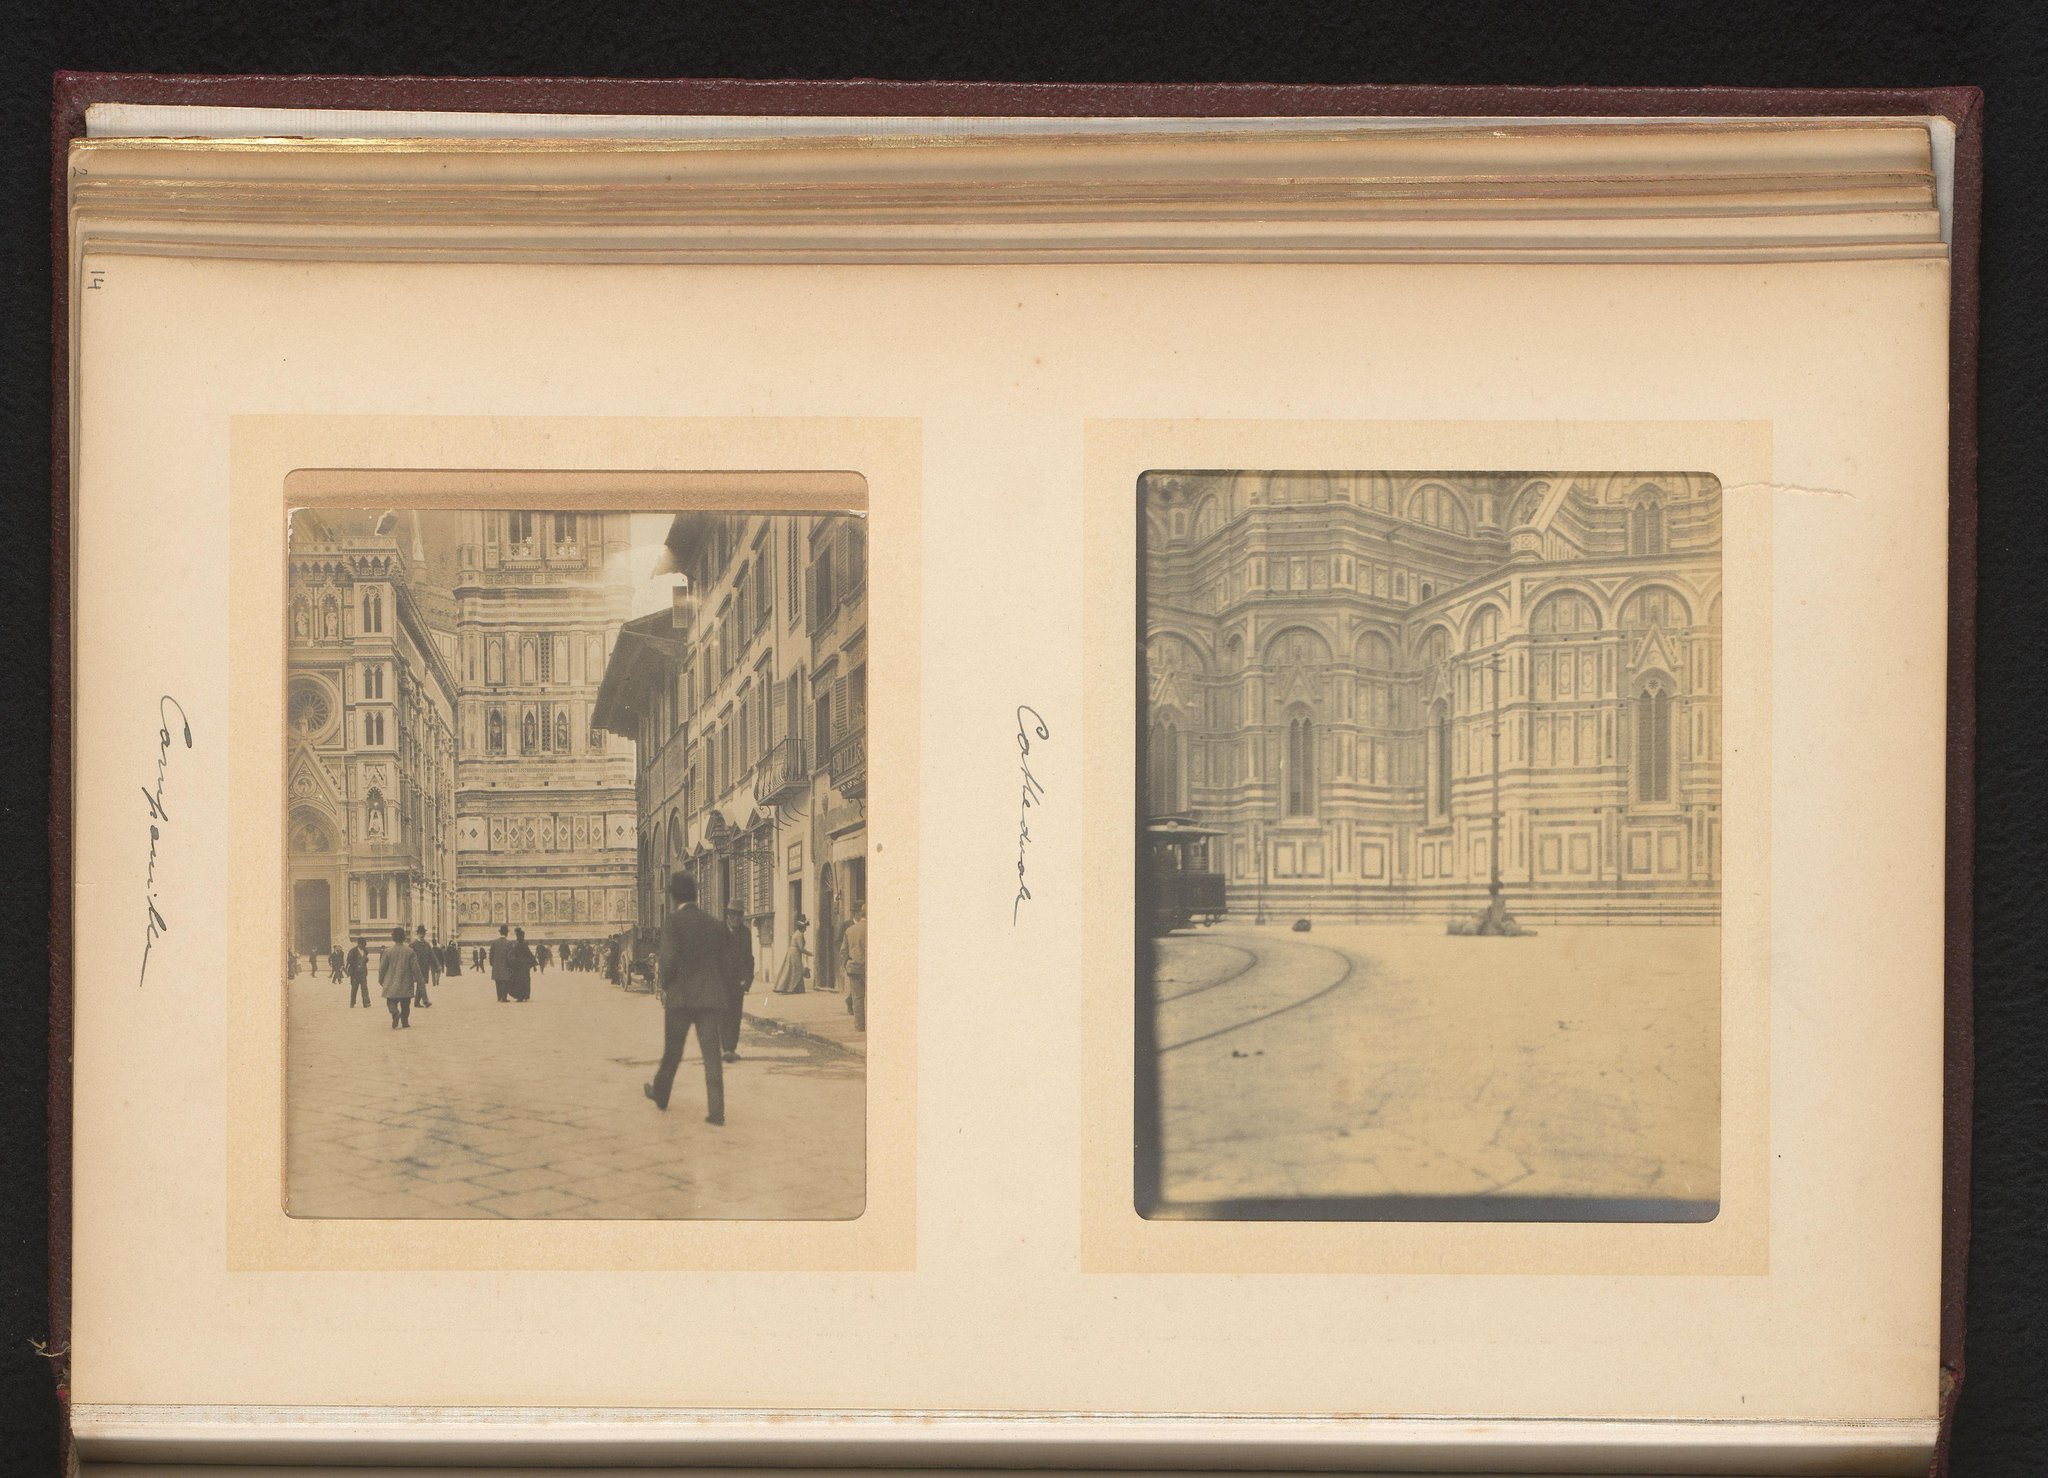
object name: album leaf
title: Twee gezichten op de Duomo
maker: Anonymous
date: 1895-1905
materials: cardboard, photographic support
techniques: gelatin silver print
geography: florence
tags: tourism, church (exterior)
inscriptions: inscription: ‘Cathedrale / Campanille’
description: Albumblad met twee foto's in Florence. Onderdeel van een fotoalbum van een reis door Italië, ca. 1900.